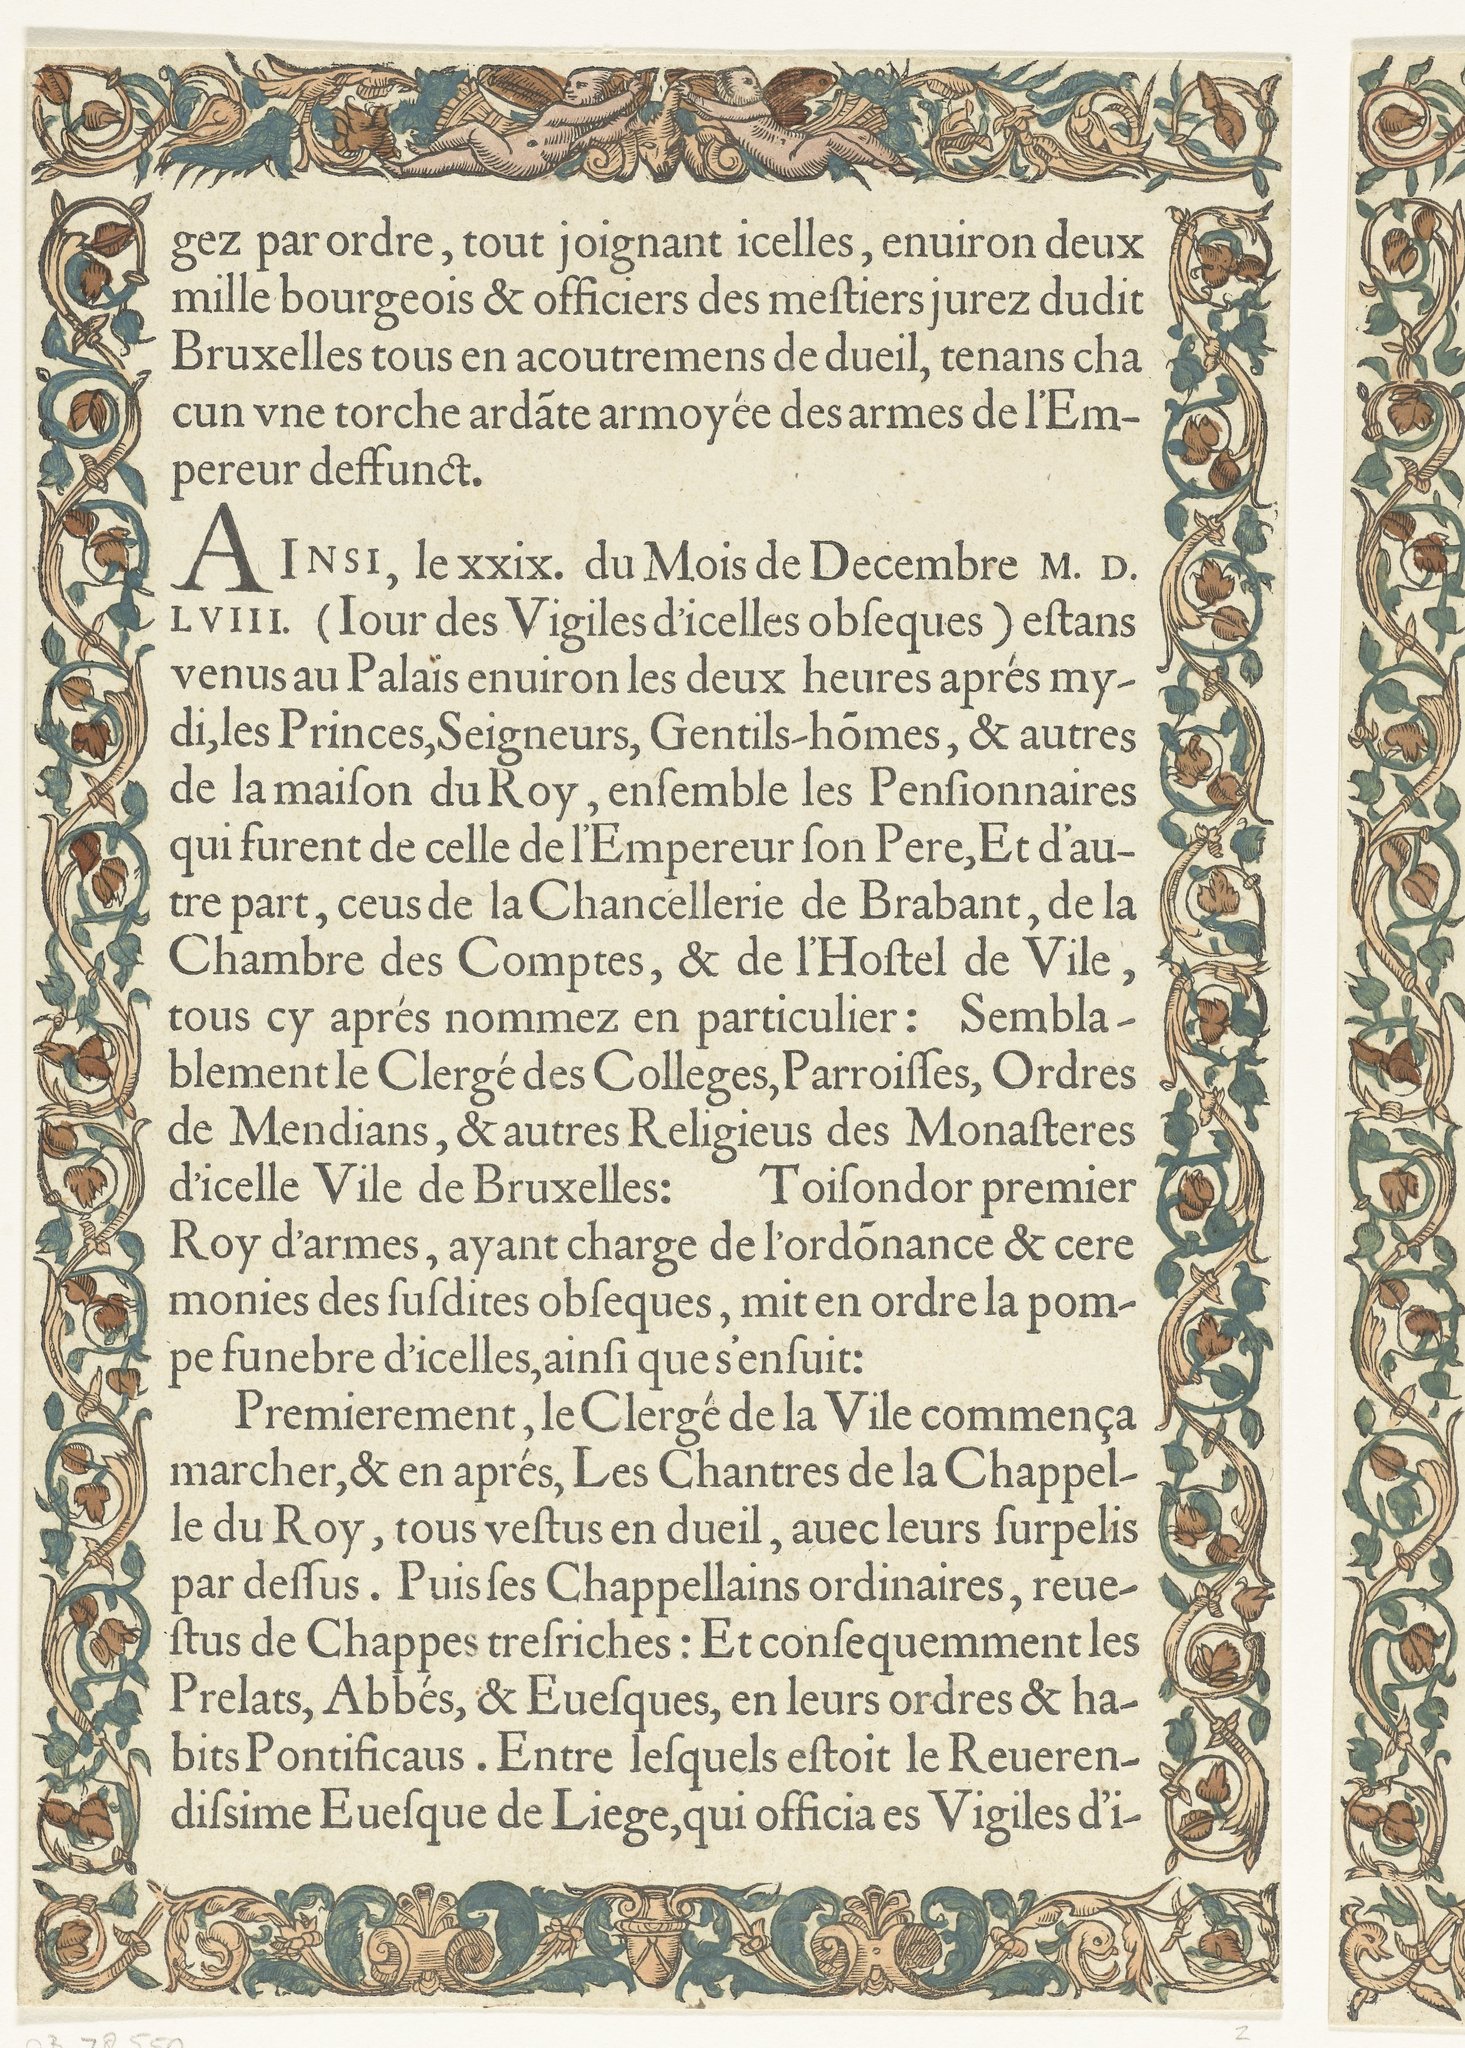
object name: text sheet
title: La magnifique, et sumptueuse Pompe Funebre, faite aus Obseques & Funerailles du tres-grand & tres-victorieus Empereur Charles Cinquième, Celebrées en la Vile de Bruxelles le XXIX. Iour du Mois de Decembre M.D.LVIII. par Philippes Roy Catholique d'Espaignes son Fils.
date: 1559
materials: paper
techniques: hand coloring, letterpress printing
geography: antwerp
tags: ghent, charles v (holy roman emperor and king of spain), brussels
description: Tekstblad bij de Begrafenisoptocht van keizer Karel V, 1558. Tekstblad met titel en beschrijving van de optocht. In ornamentele randen in houtsnede. Tweede blad.